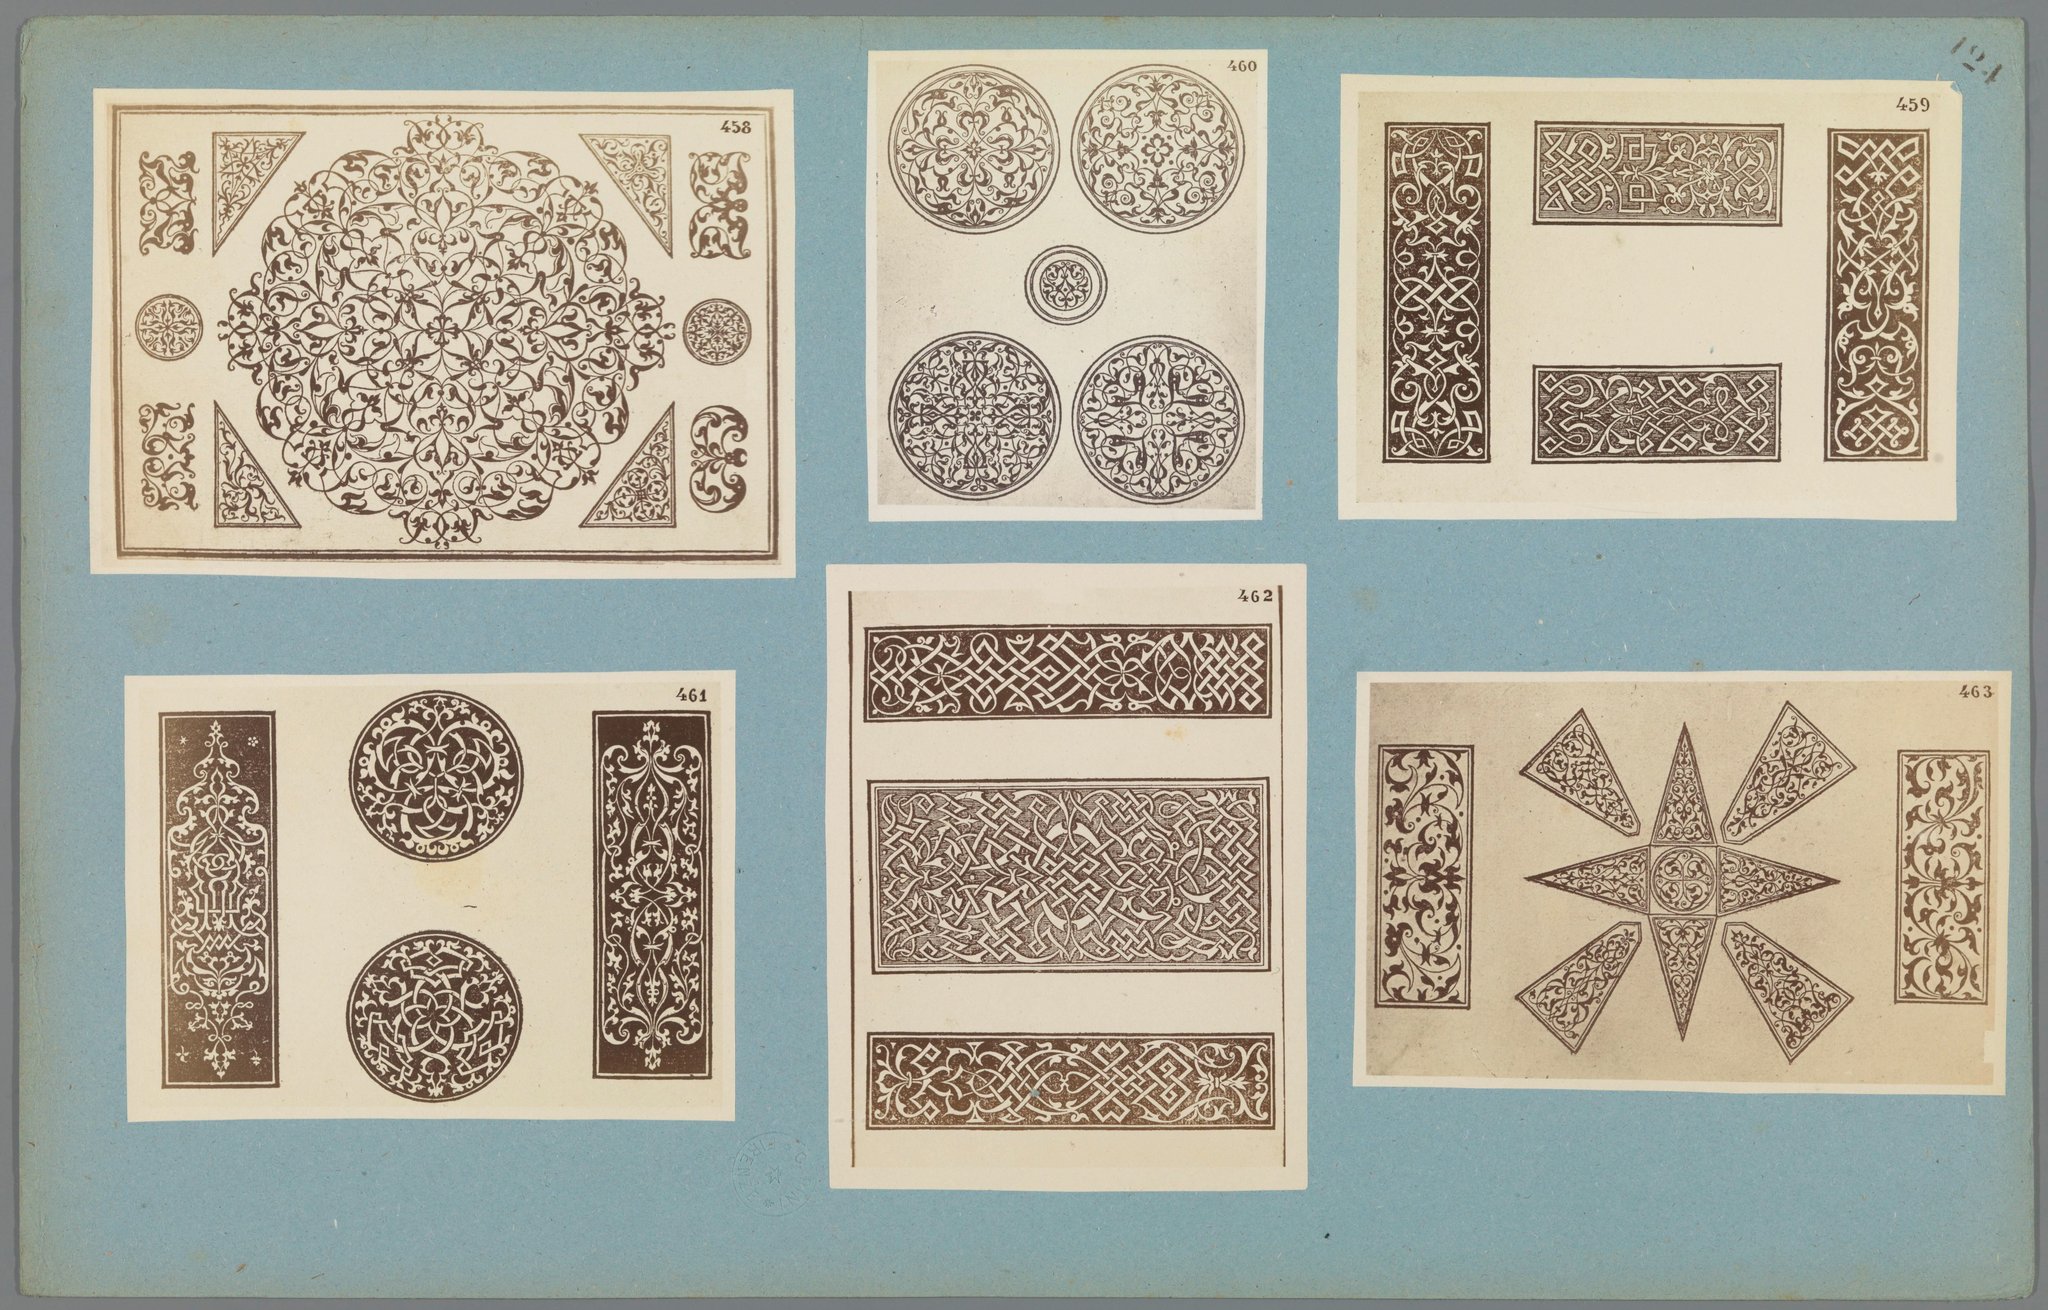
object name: reproduction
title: Zes fotoreproducties van ornamentprenten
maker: Anonymous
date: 1875-1900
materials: cardboard, photographic support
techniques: albumen print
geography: europe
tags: foliage, tendrils, branches ~ ornament - aa - stylized, ornamental birds, abstract interlace, knotwork ~ ornament, europe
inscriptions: number: ‘461’, collector's mark: Lugt 3937, number: ‘462’, number: ‘124’, number: ‘460’, name: ‘C. PINI FIRENZE’, number: ‘463’, number: ‘458’, number: ‘459’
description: Linksboven (458) een prent van een geabstraheerd plantmotief, linksonder (461) een prent van abstracte patronen in twee cirkels en rechthoeken, middenboven (460) een prent van vijf cirkels met daarin abstracte patronen, middenonder (462) een prent van drie rechthoeken met knooppatronen, rechtsboven (459) een prent van vier rechthoeken met daarin knooppatronen, rechtsonder (463) een prent van een stervorm en rechthoeken met daarin plantmotieven.